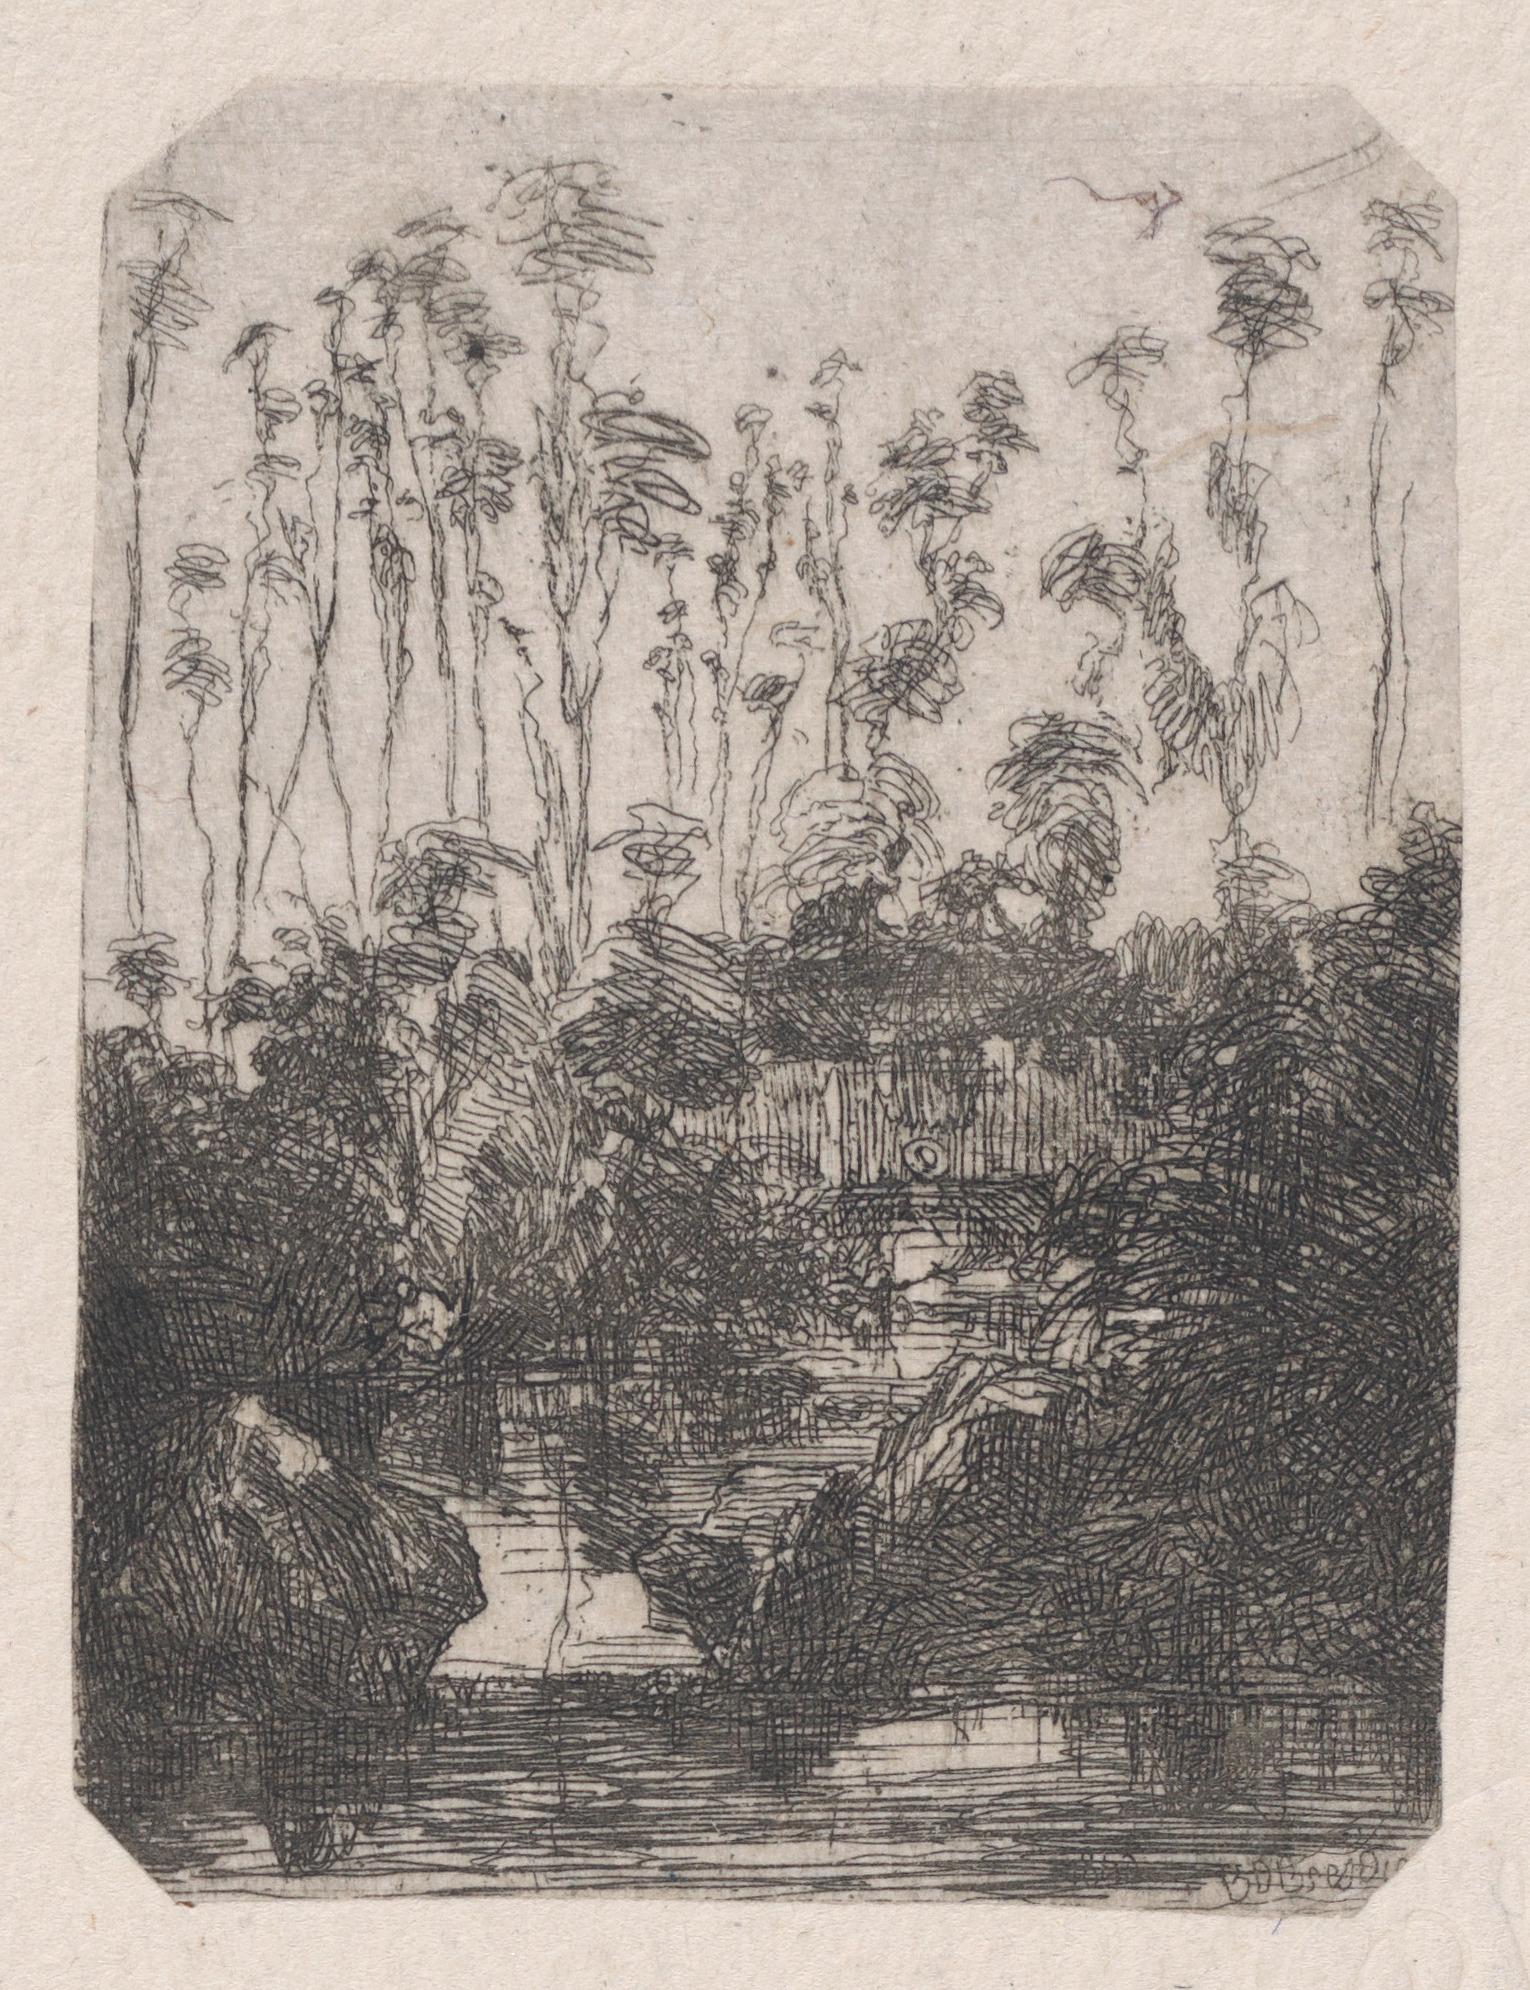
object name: print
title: La Marais (The Swamp)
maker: rodolphe bresdin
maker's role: artist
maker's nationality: french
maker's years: 1822-1885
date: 1849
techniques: etching